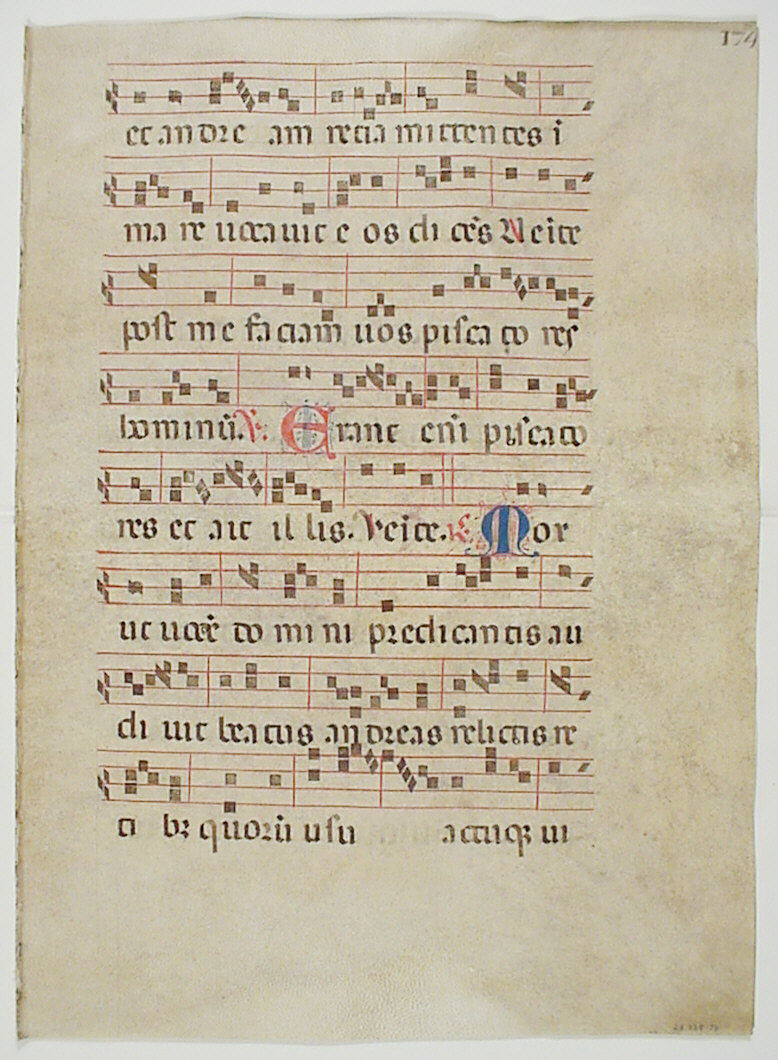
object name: antiphonary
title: Bifolium from an Antiphonary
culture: italian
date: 1301-1400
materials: ink, metal leaf, parchment, paint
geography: italy